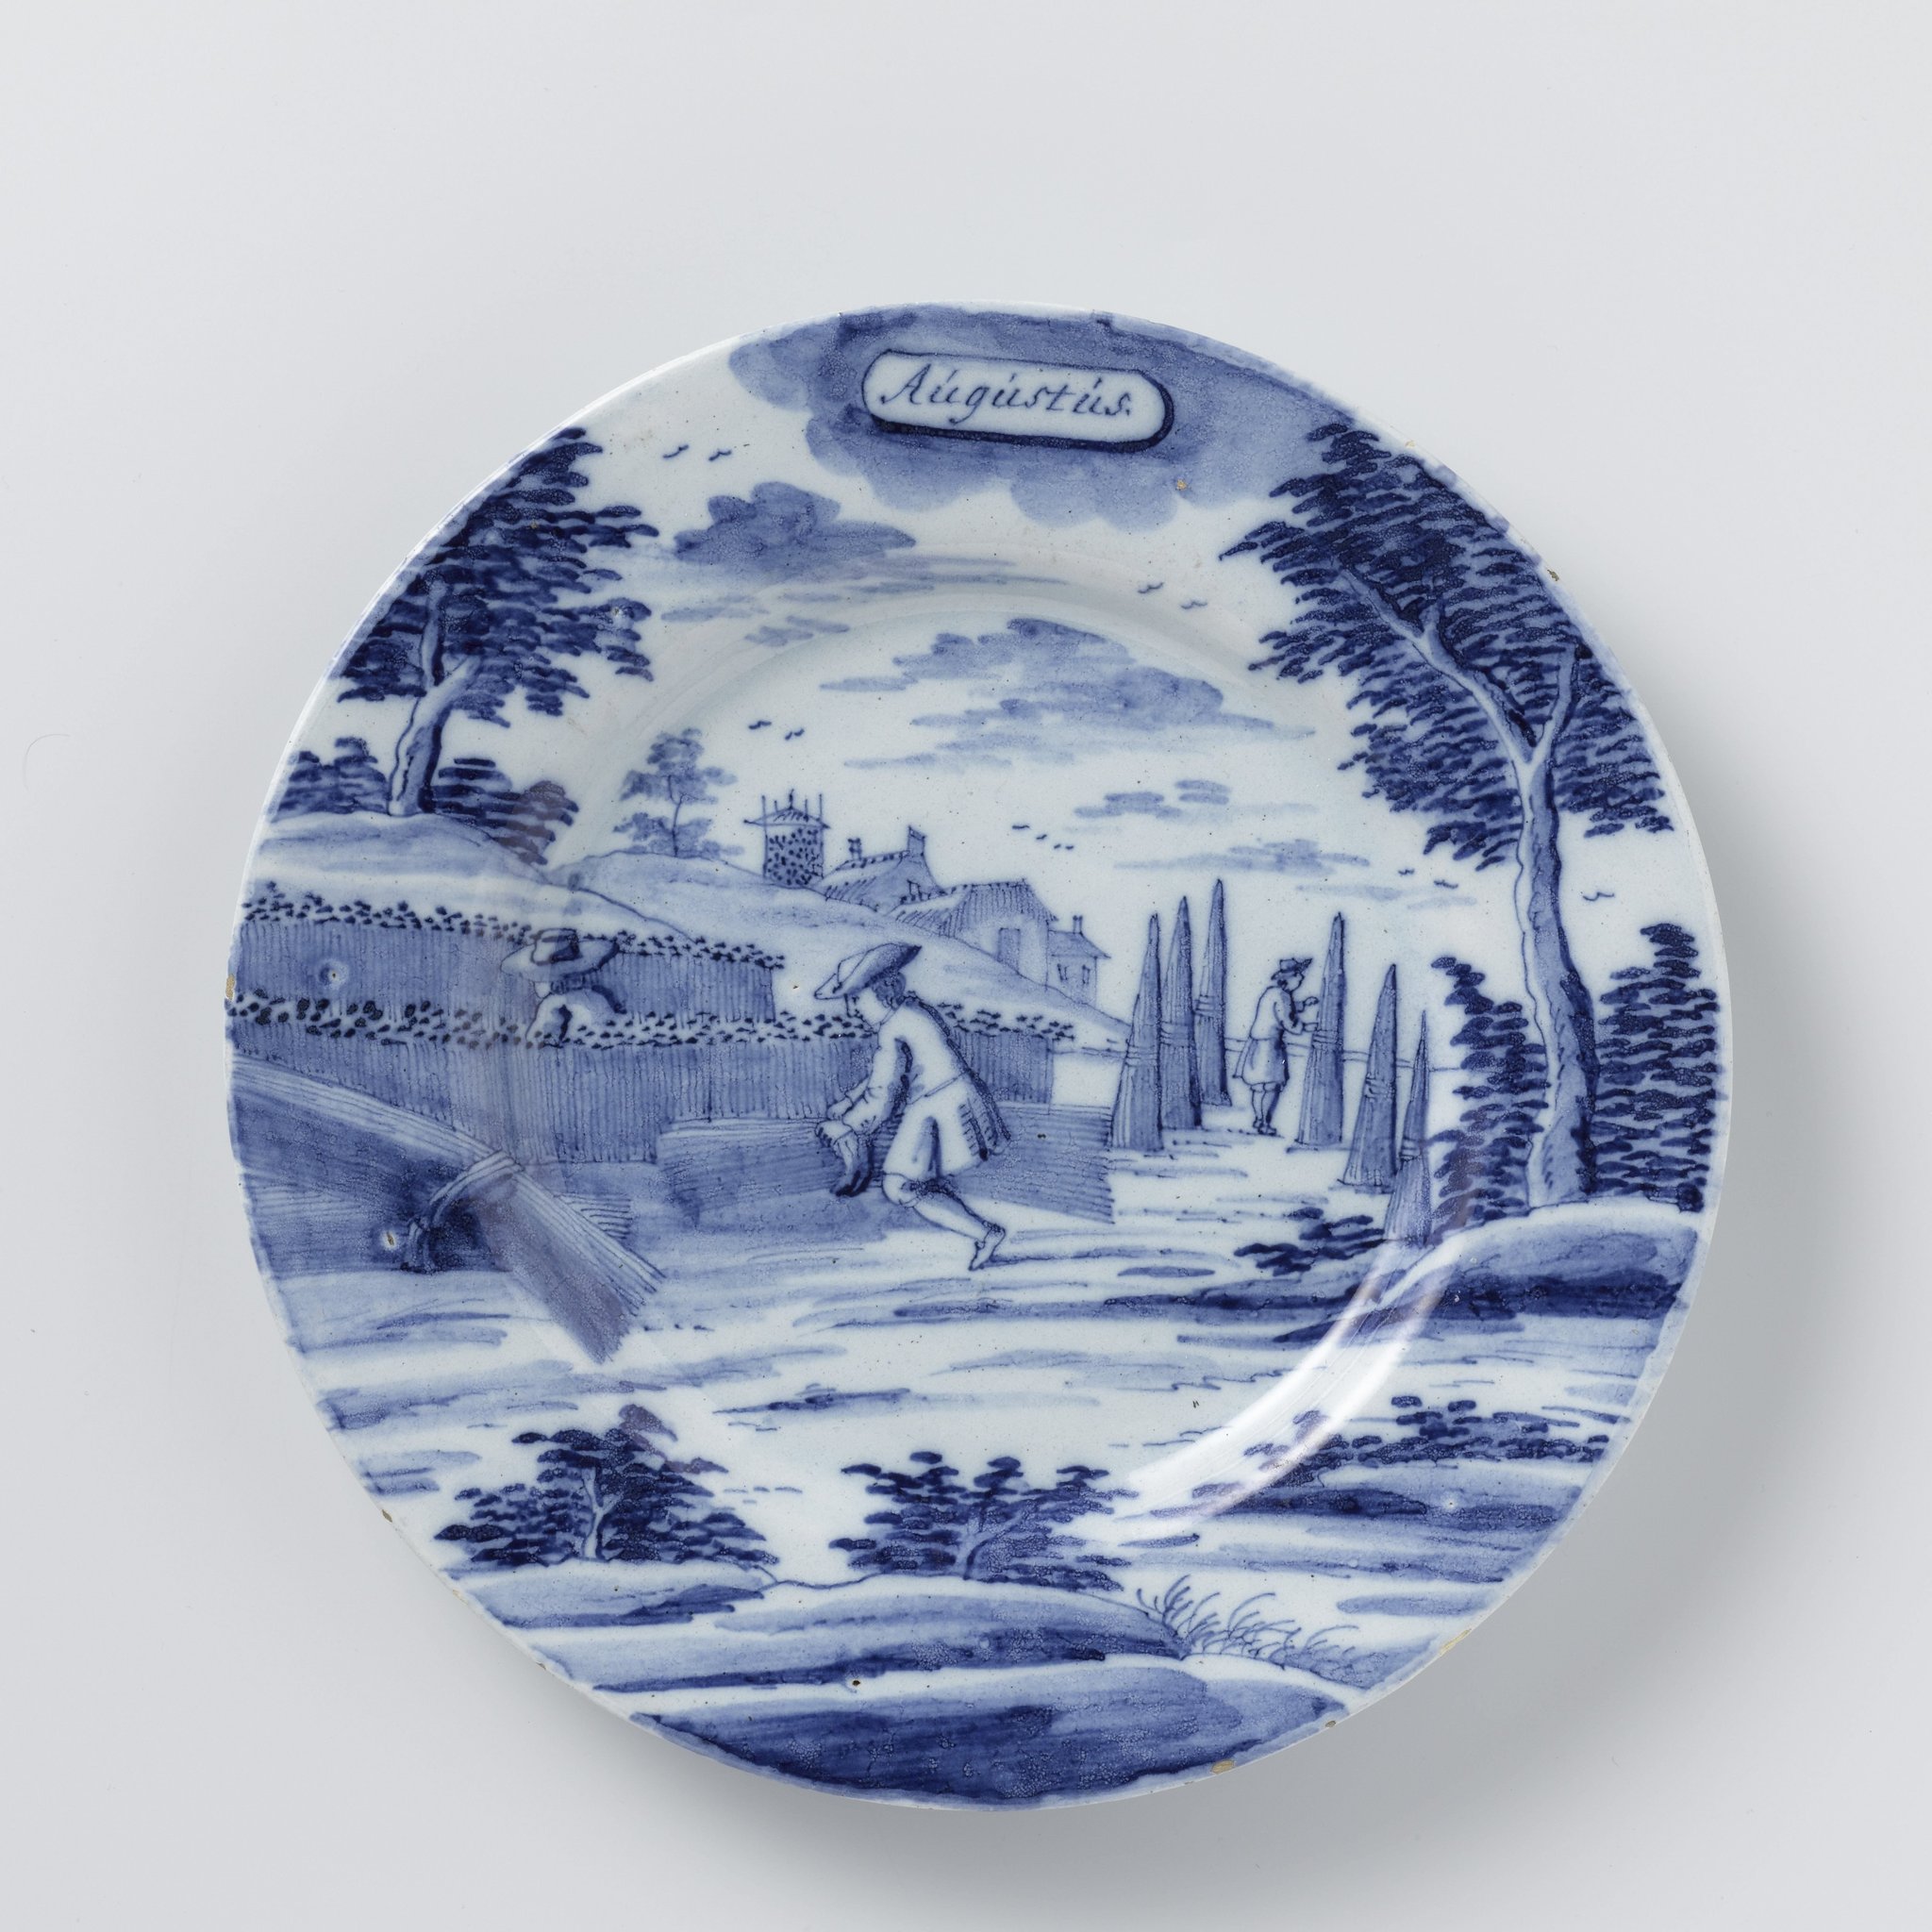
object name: plate dish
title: Bord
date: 1750-1780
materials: faience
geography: delft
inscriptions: mark: ‘figuratief teken bijtje’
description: Bord van faience, uit de serie de 12 maanden. Voorstellende de maand augustus. Afgebeeld is: de oogst, met de tekst: Augustus.